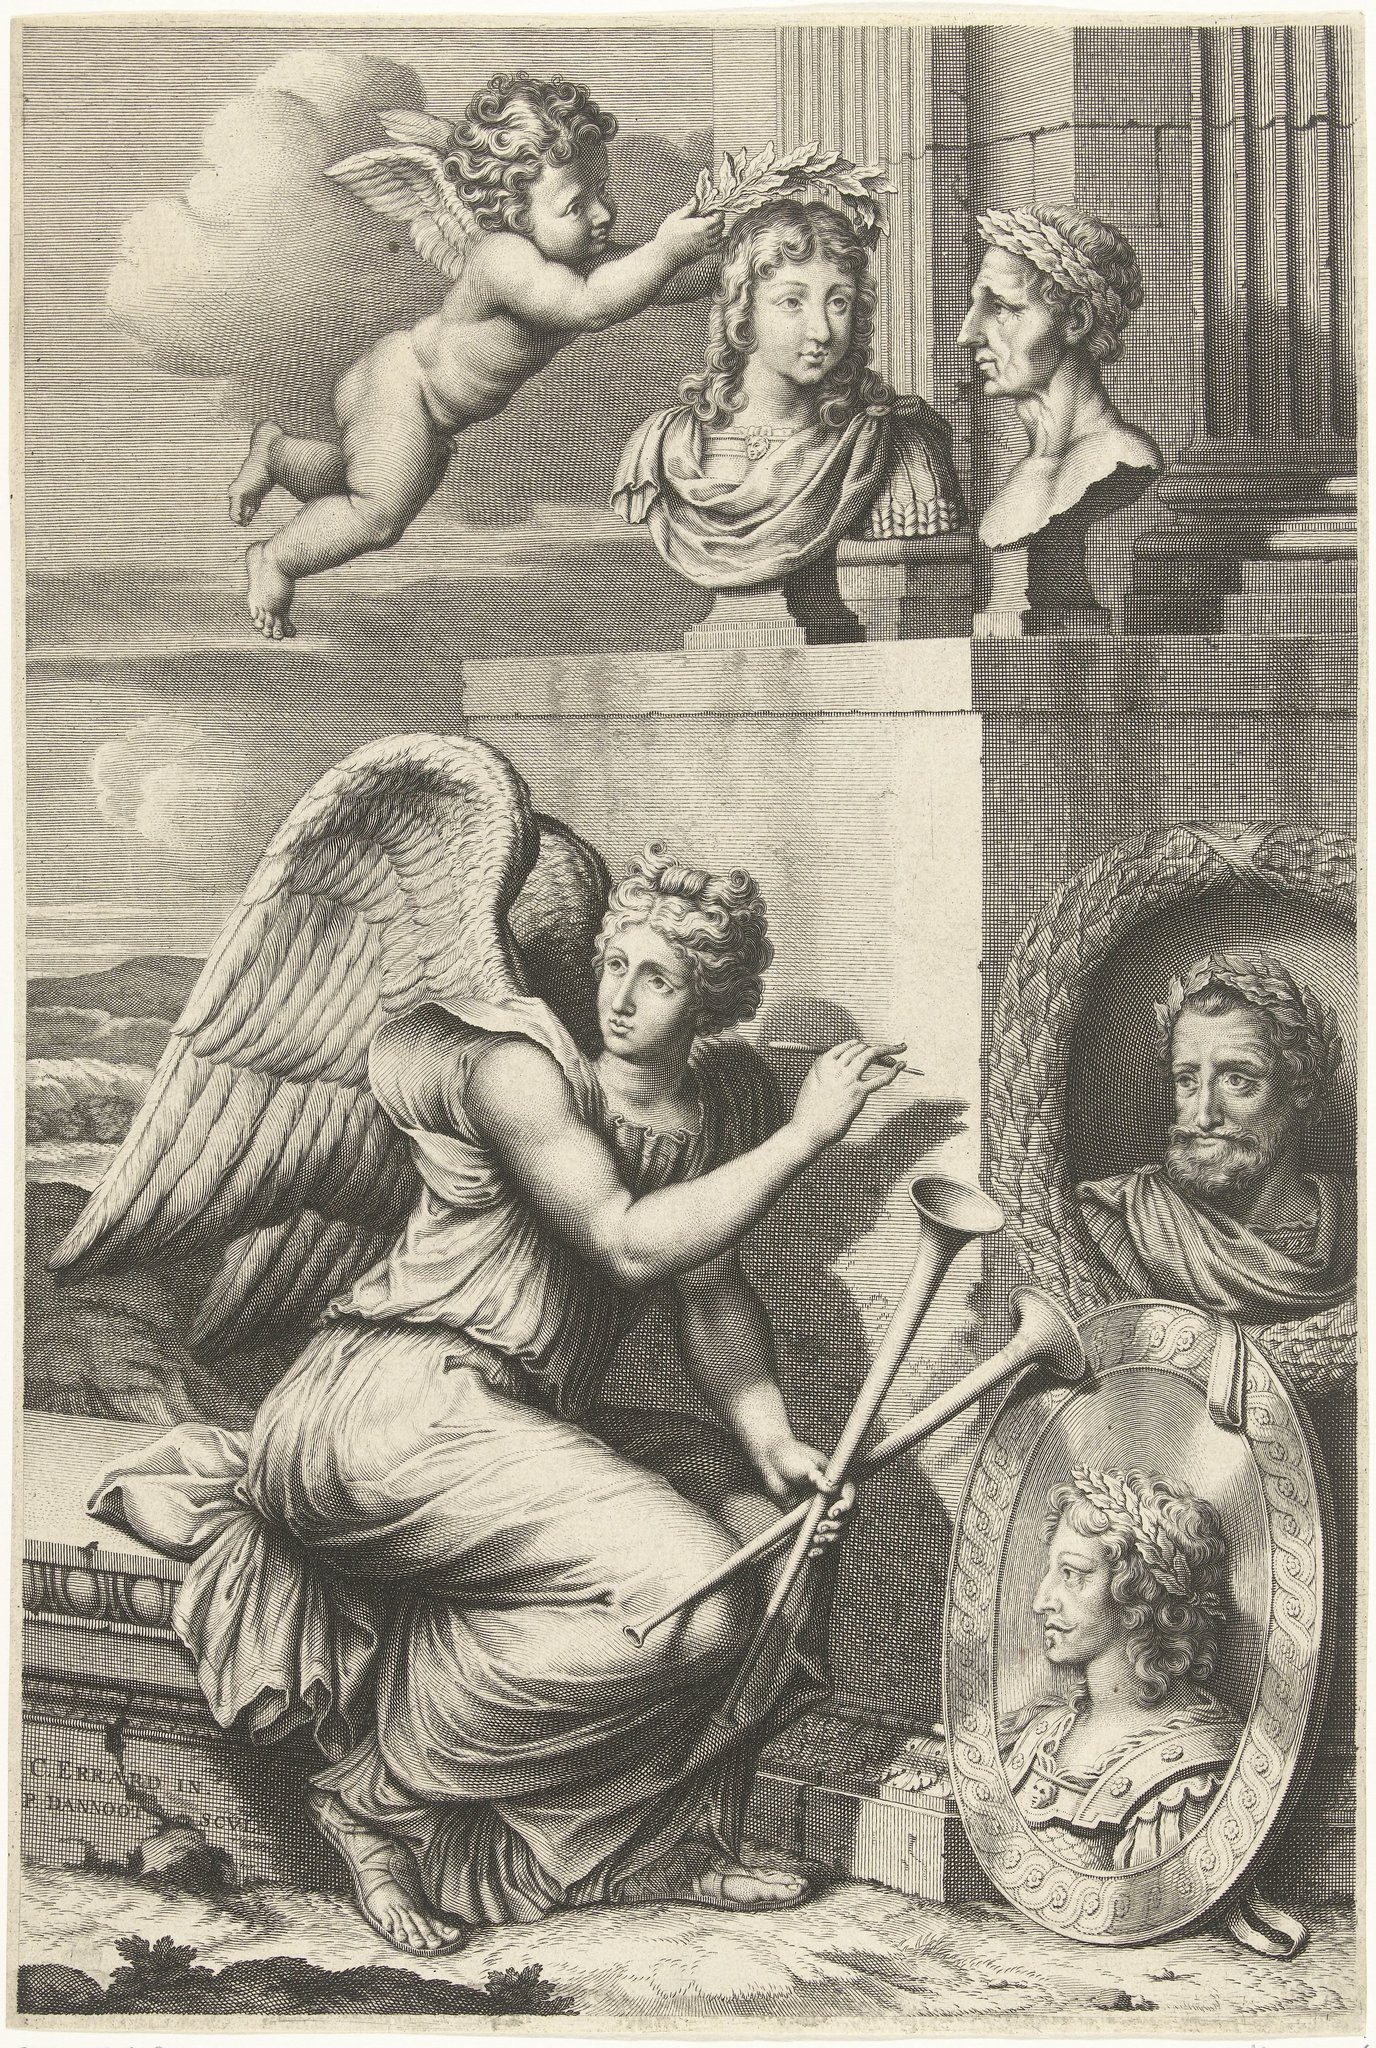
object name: print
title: Faam zittend bij portretten van heersers met lauwerkransen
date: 1644-1692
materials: paper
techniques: engraving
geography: antwerp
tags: fama as roman personification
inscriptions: collector's mark: Lugt 2228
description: Titelpagina (frontispiece) voor: Francesco Amico, Cursus Theologicus scholasticus et moralis, Antwerpen, Willem Lesteens (uitgever), 1650, aldus Hollstein.